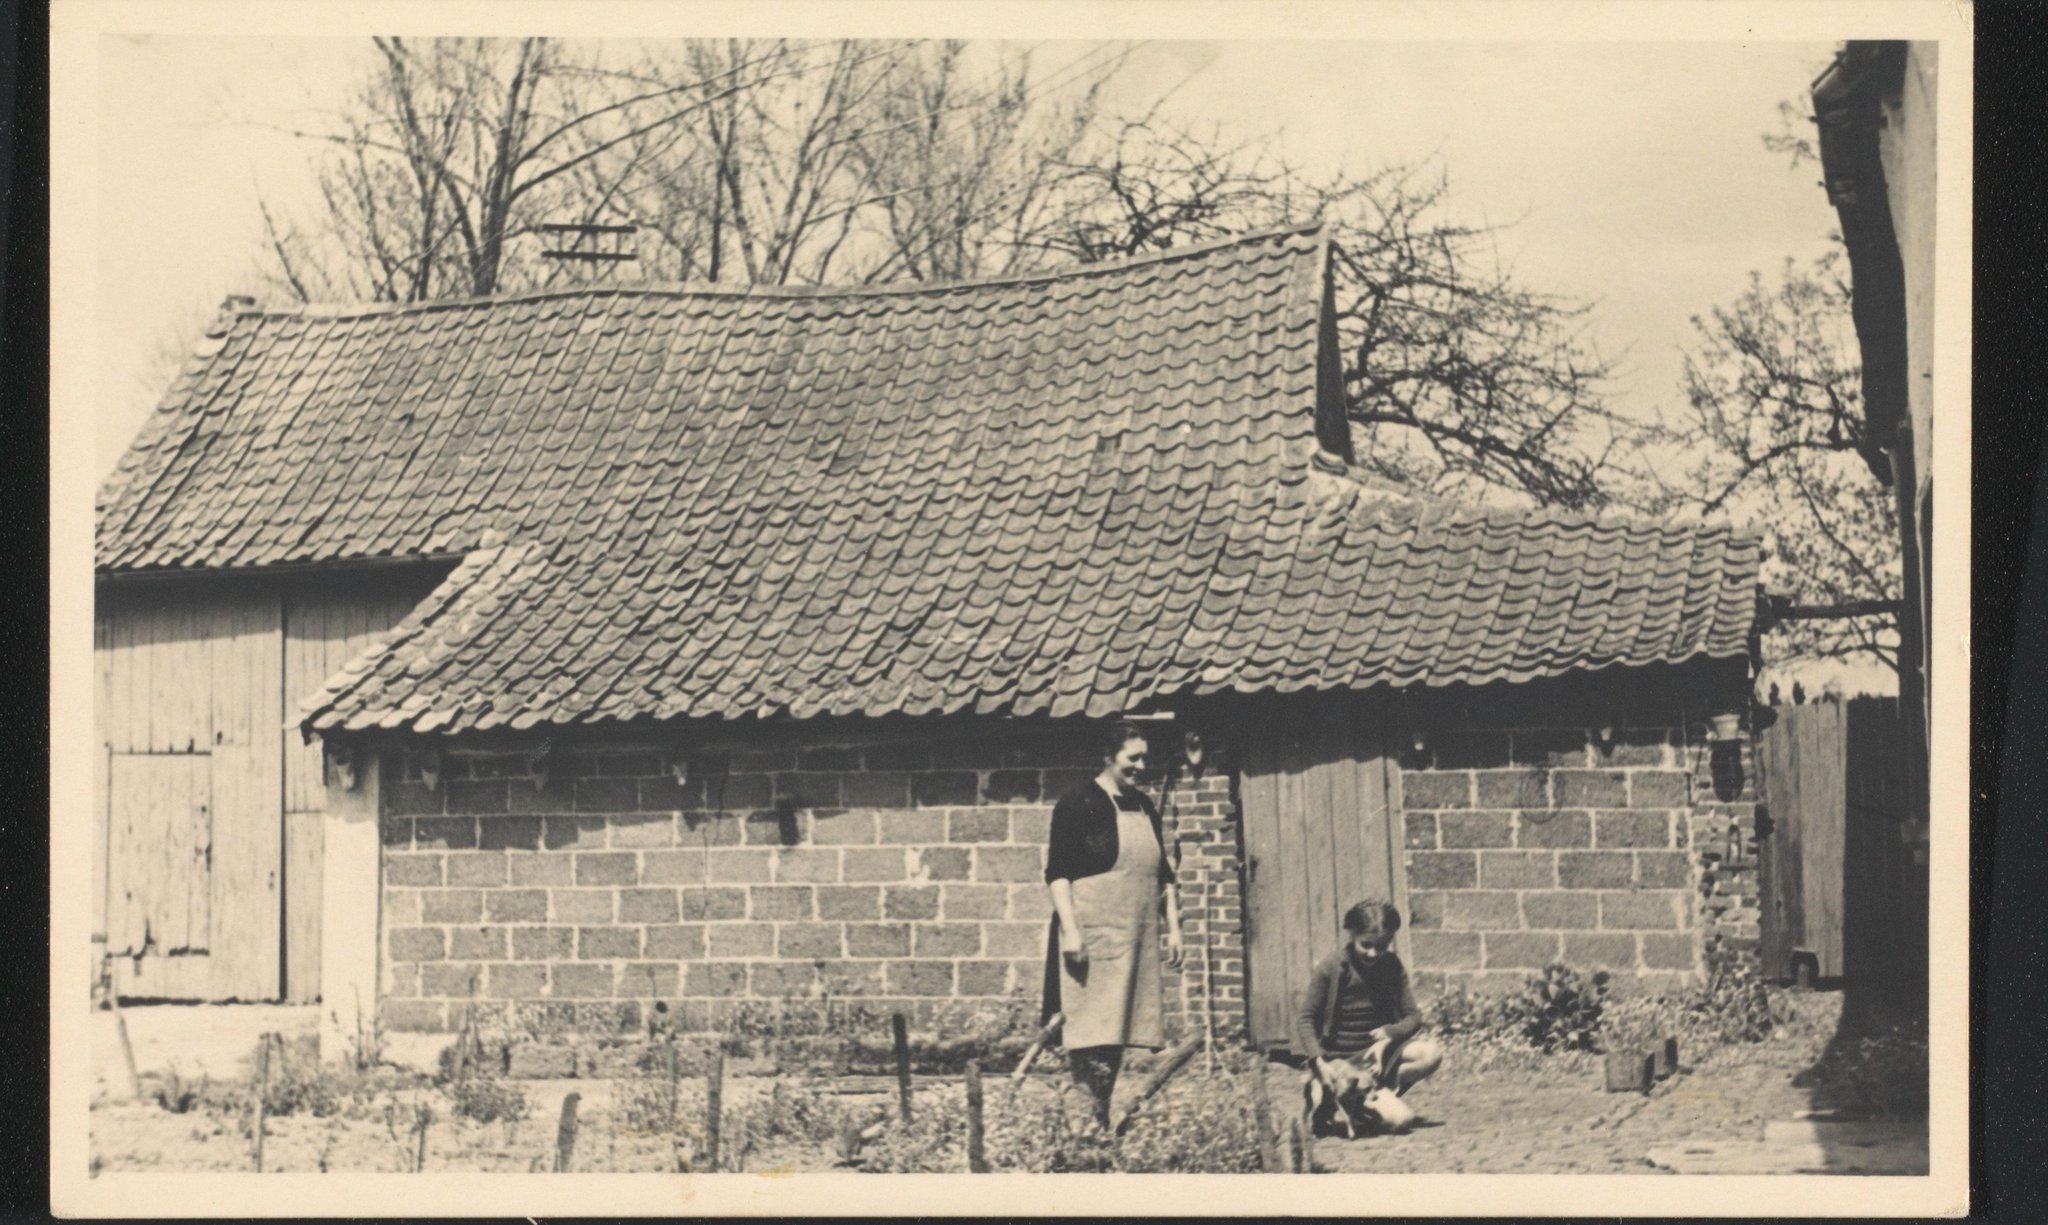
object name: ansichtkaart, prentbriefkaart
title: Vrouw en een meisje bij een schuur, vermoedelijk in Blicquy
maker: Anonymous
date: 1920-1930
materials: photographic support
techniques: gelatin silver print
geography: blicquy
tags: barn